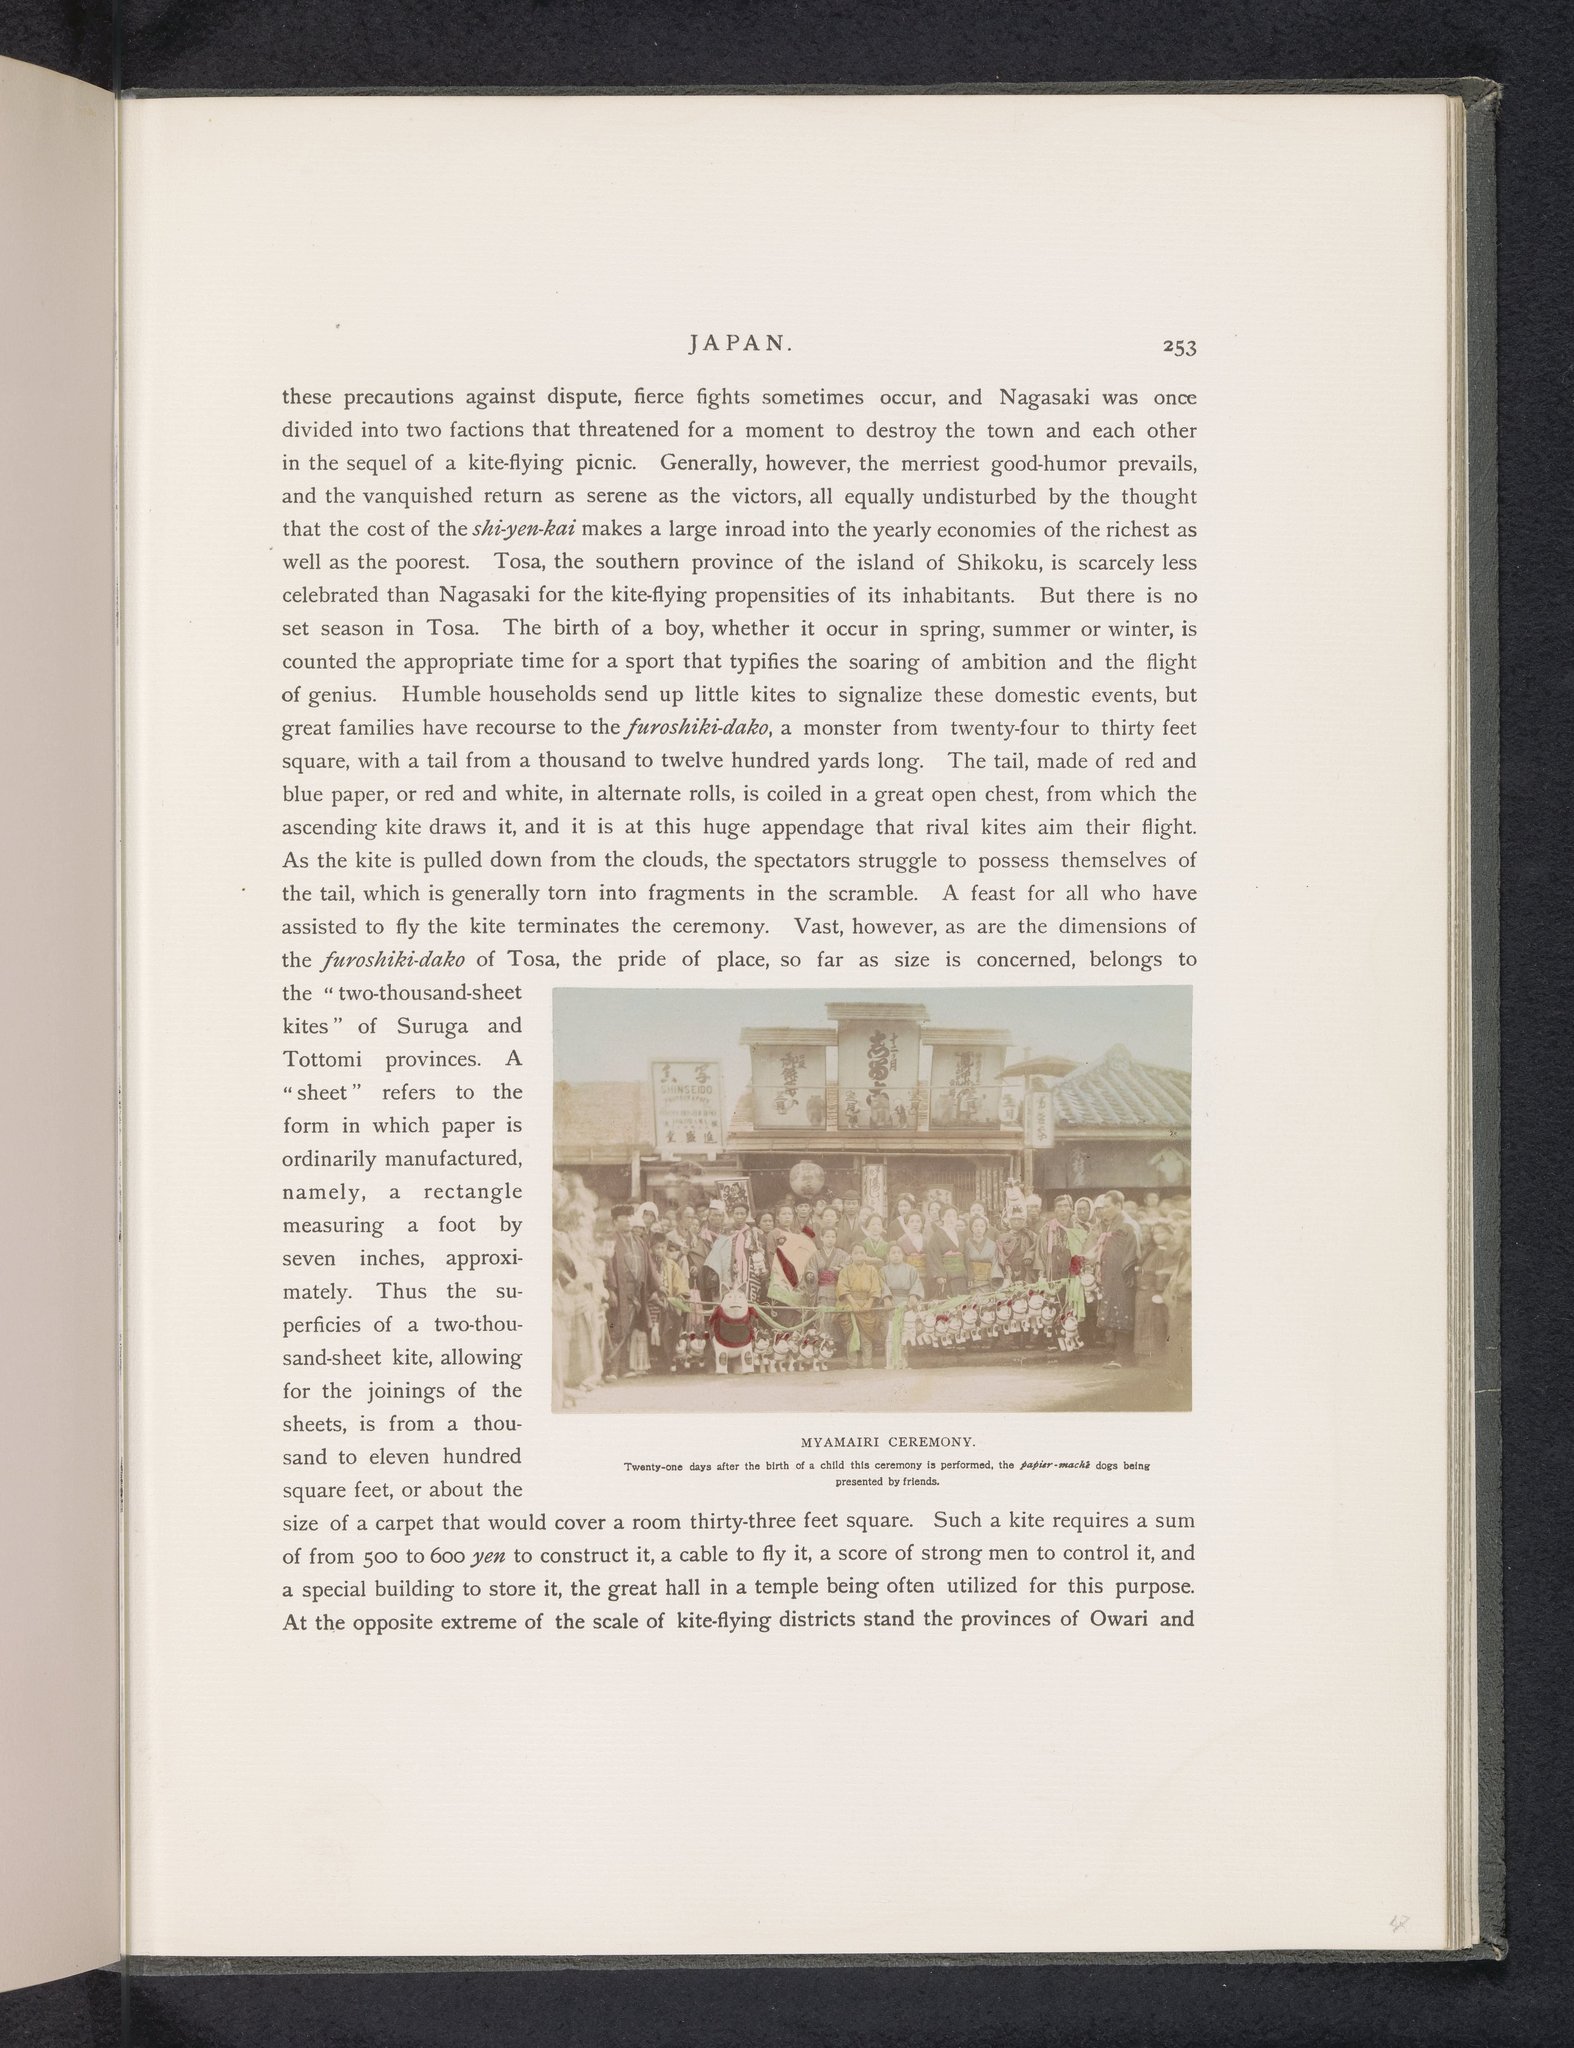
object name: photograph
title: Miyamairi ceremony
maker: Anonymous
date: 1887-1897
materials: photographic support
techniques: albumen print, hand coloring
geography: japan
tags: façade (of house or building), anonymous historical persons portrayed in a group, in a group-portrait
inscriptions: inscription: ‘Twenty-one days after the birth of a child this ceremony is performed, the papier-maché dogs being presented by friends.’